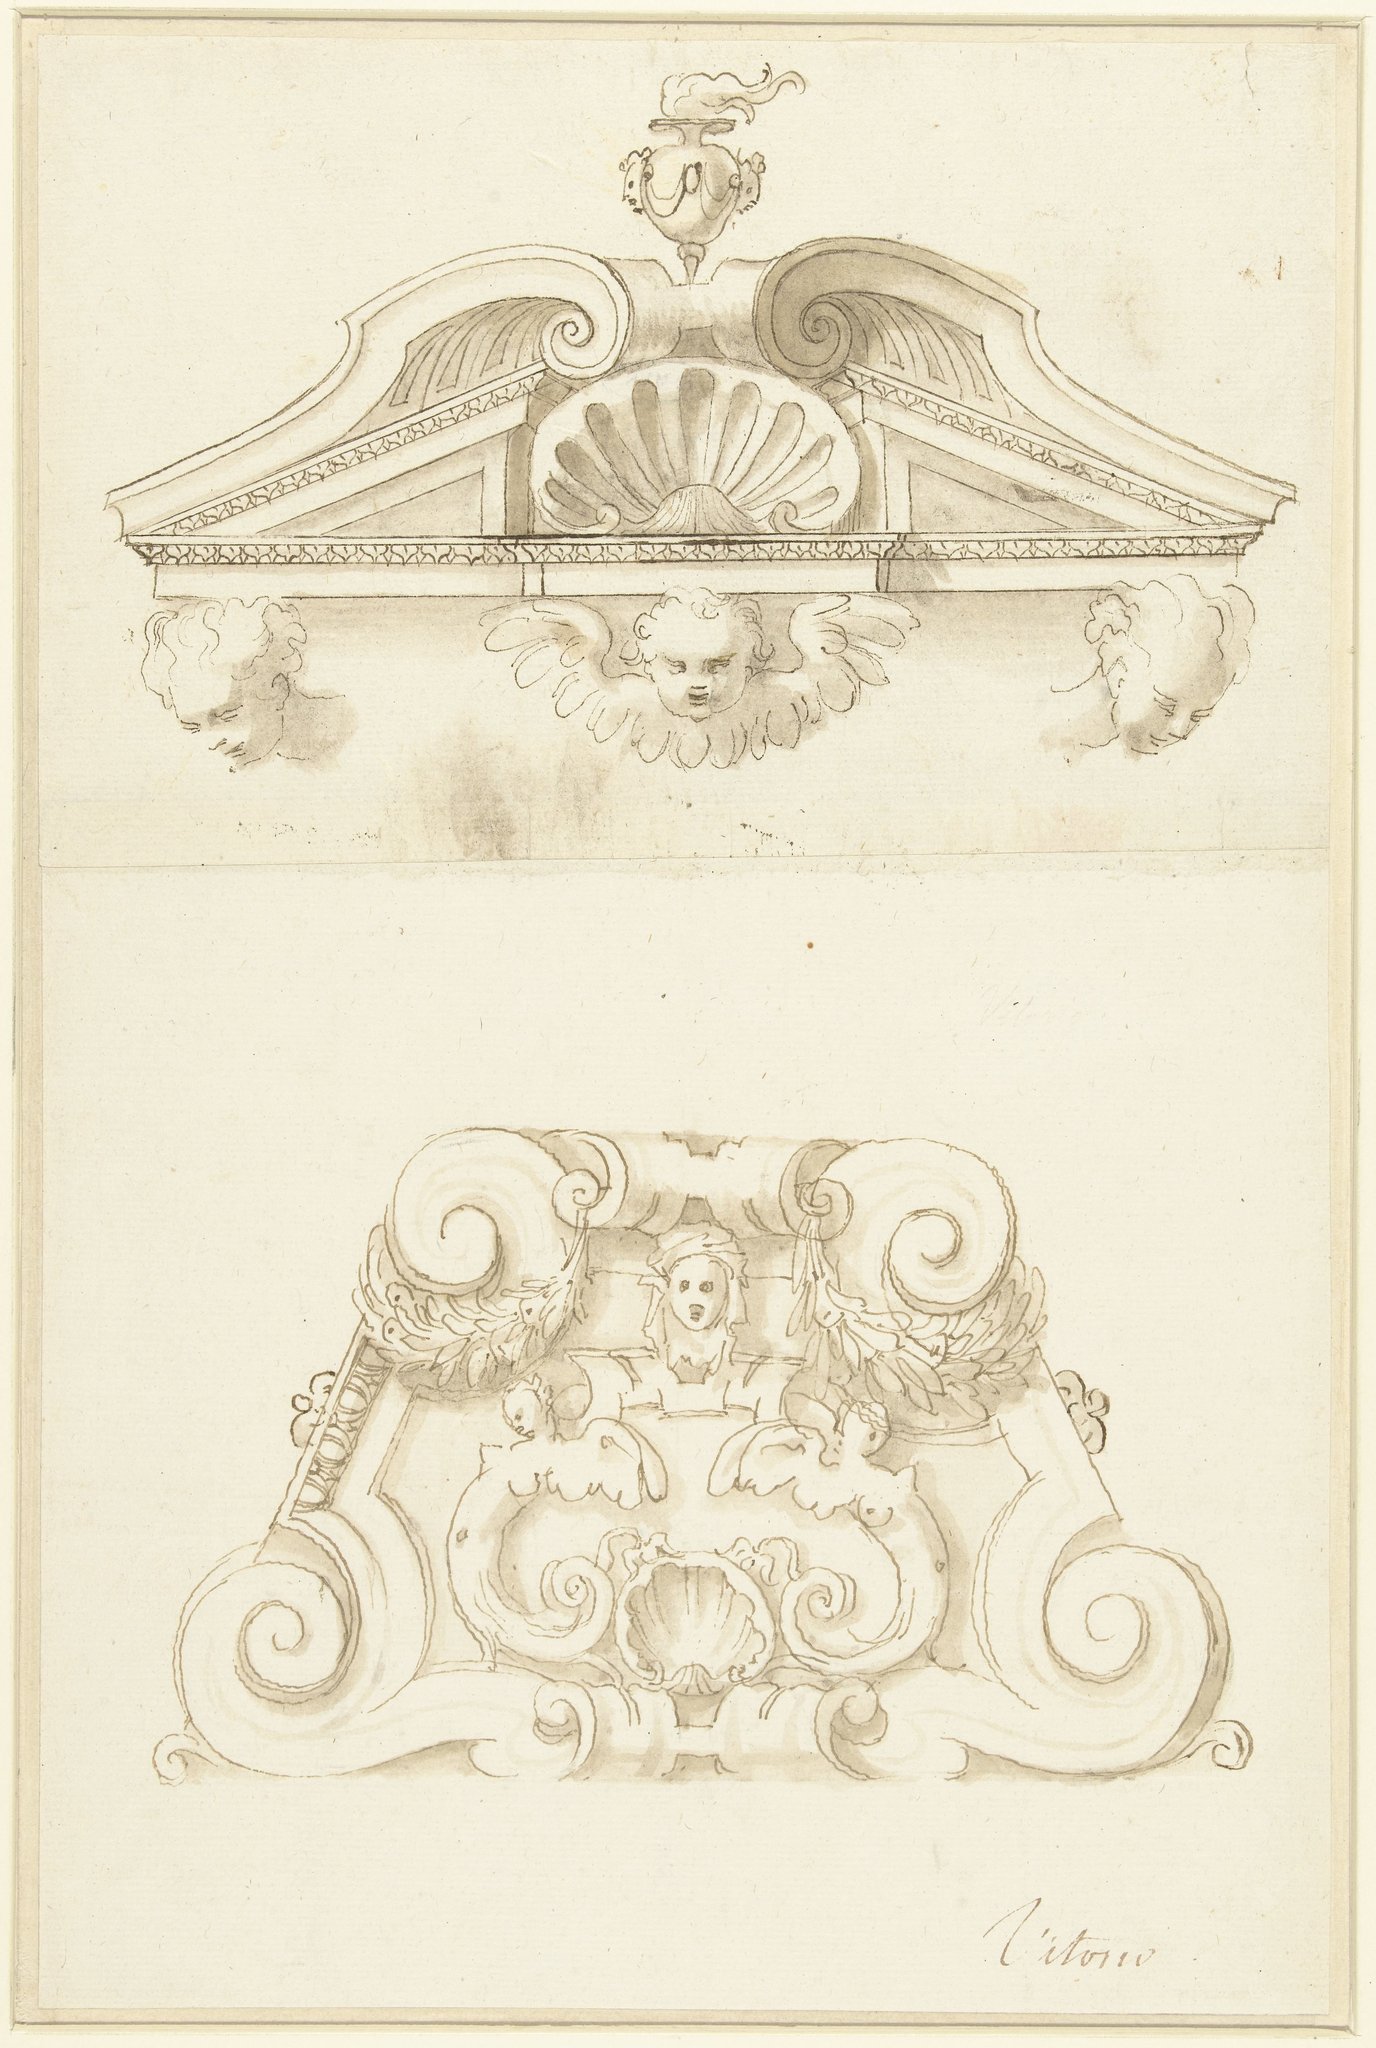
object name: design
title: Twee ornamentale schoorsteenontwerpen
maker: vittorio maria bigari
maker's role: draughtsman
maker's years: 1692-1776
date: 1702-1776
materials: ink, paper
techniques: brush, pen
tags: ornaments ~ art, architectural detail, architectural design or model